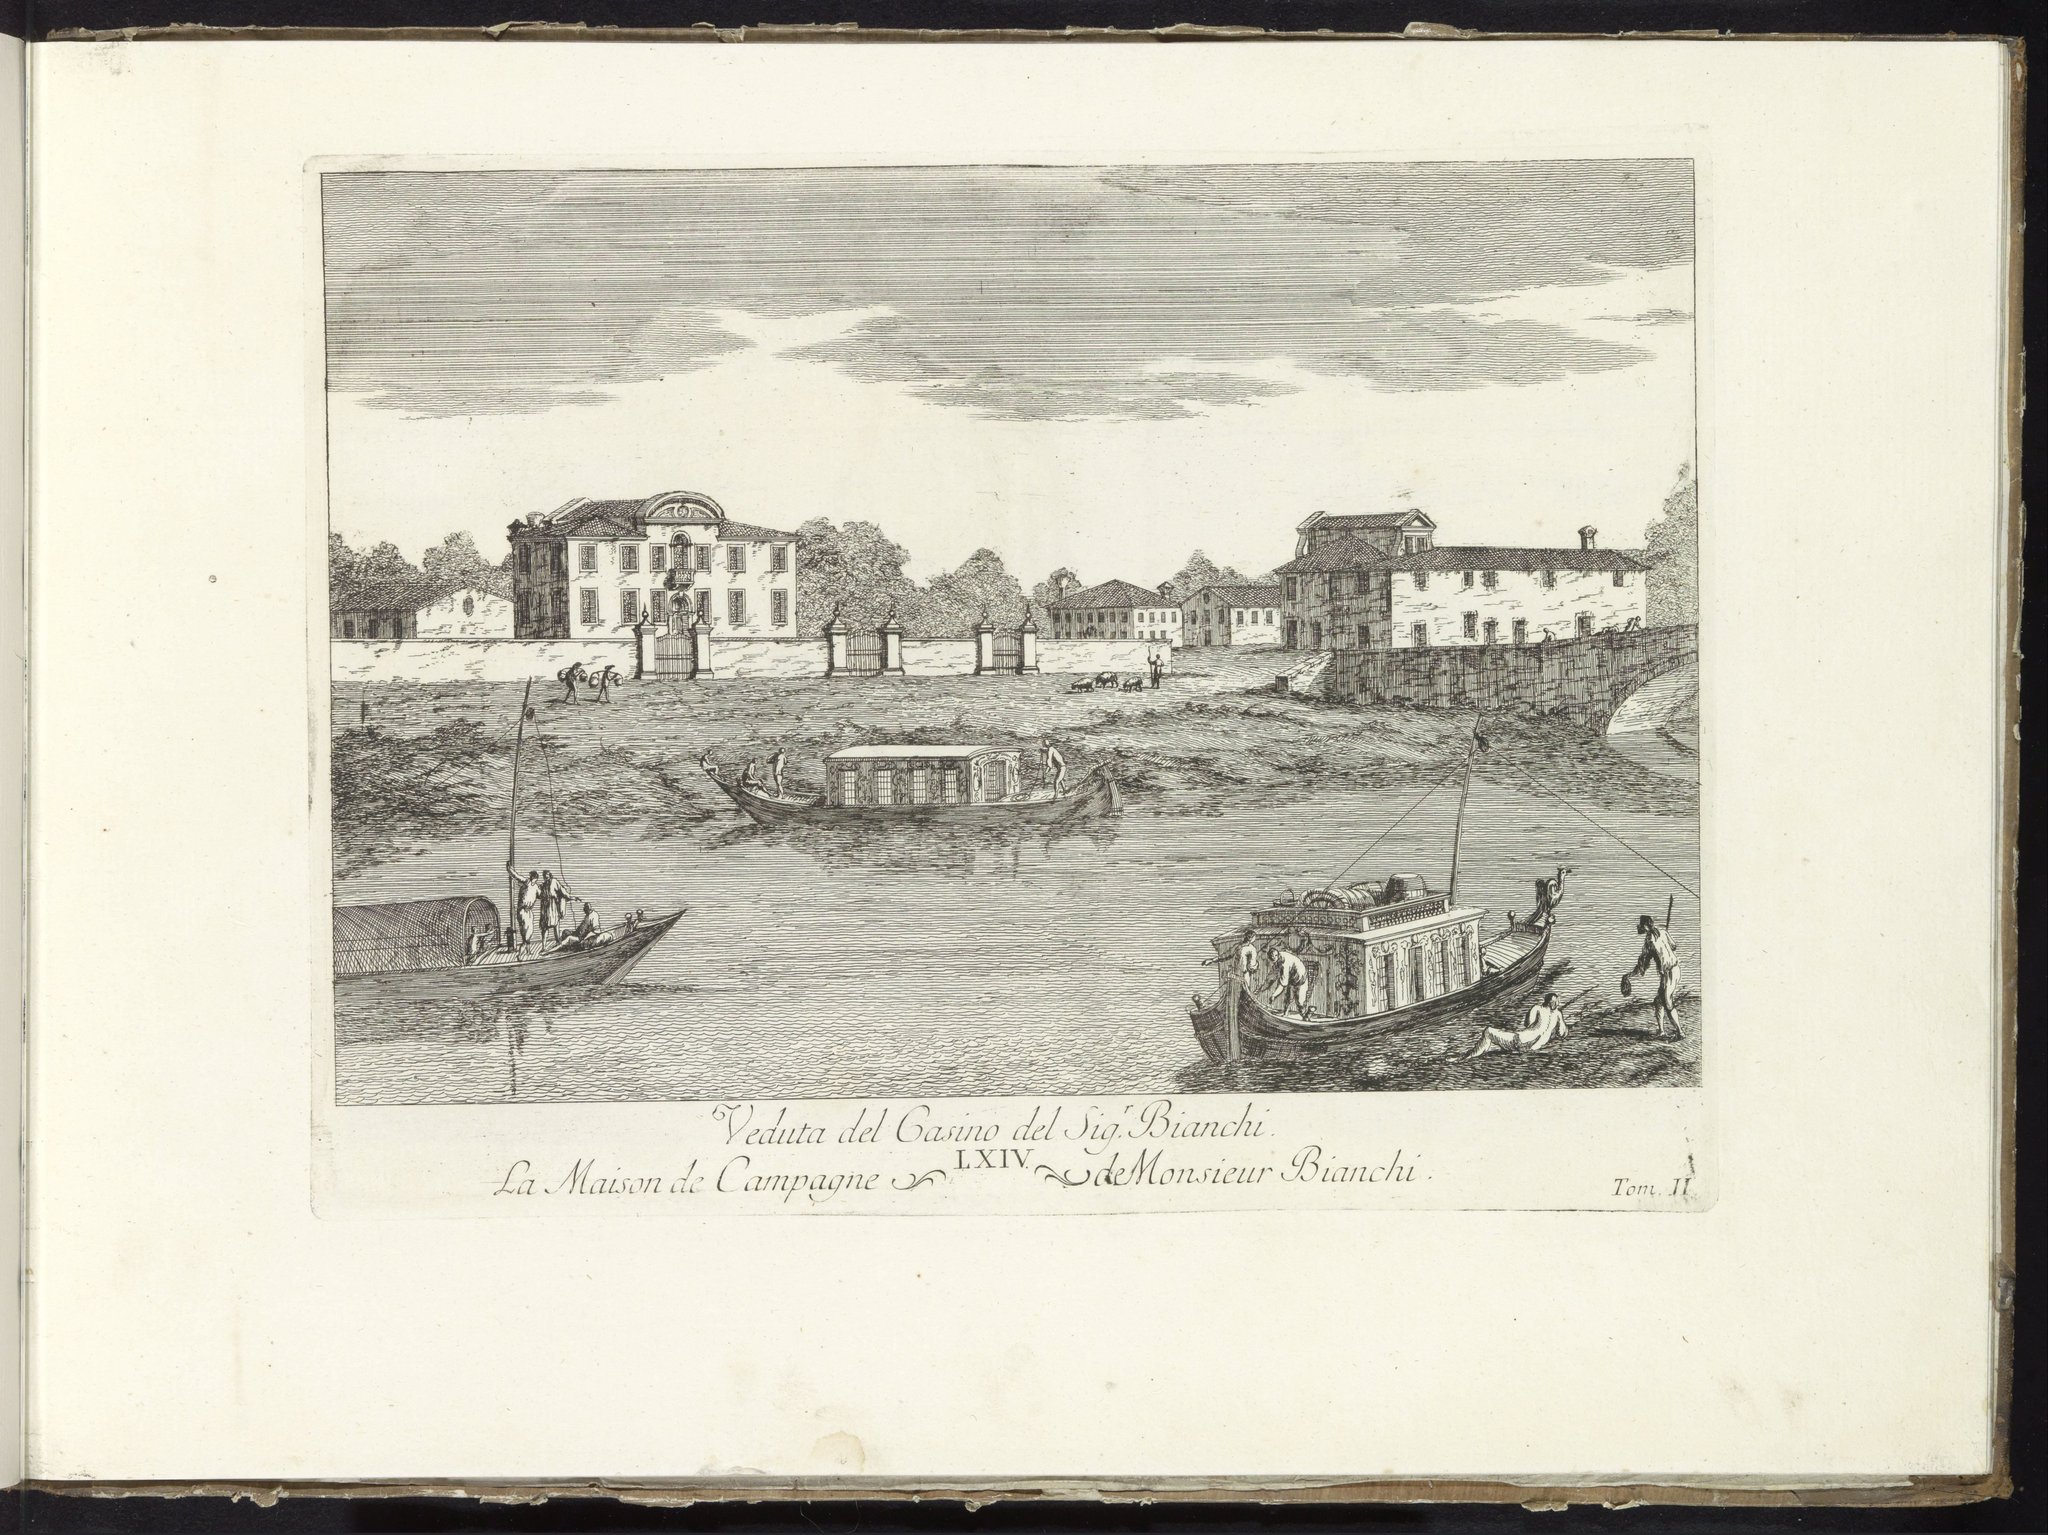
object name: print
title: Le delicie della Brenta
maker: giovanni francesco costa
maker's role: draughtsman, painter, print maker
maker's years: -1773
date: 1750-1760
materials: paper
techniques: etching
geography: italy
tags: river, tow-boat, towing-barge, hôtel, i.e. small palace in city, gondola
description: Gezicht op het Casino del Signore Bianchi aan de rivier de Brenta. Op het water varen drie schuiten. Genummerd midden onder: LXIV en rechtsonder: Tom: II. Deze prent maakt deel uit van een album.